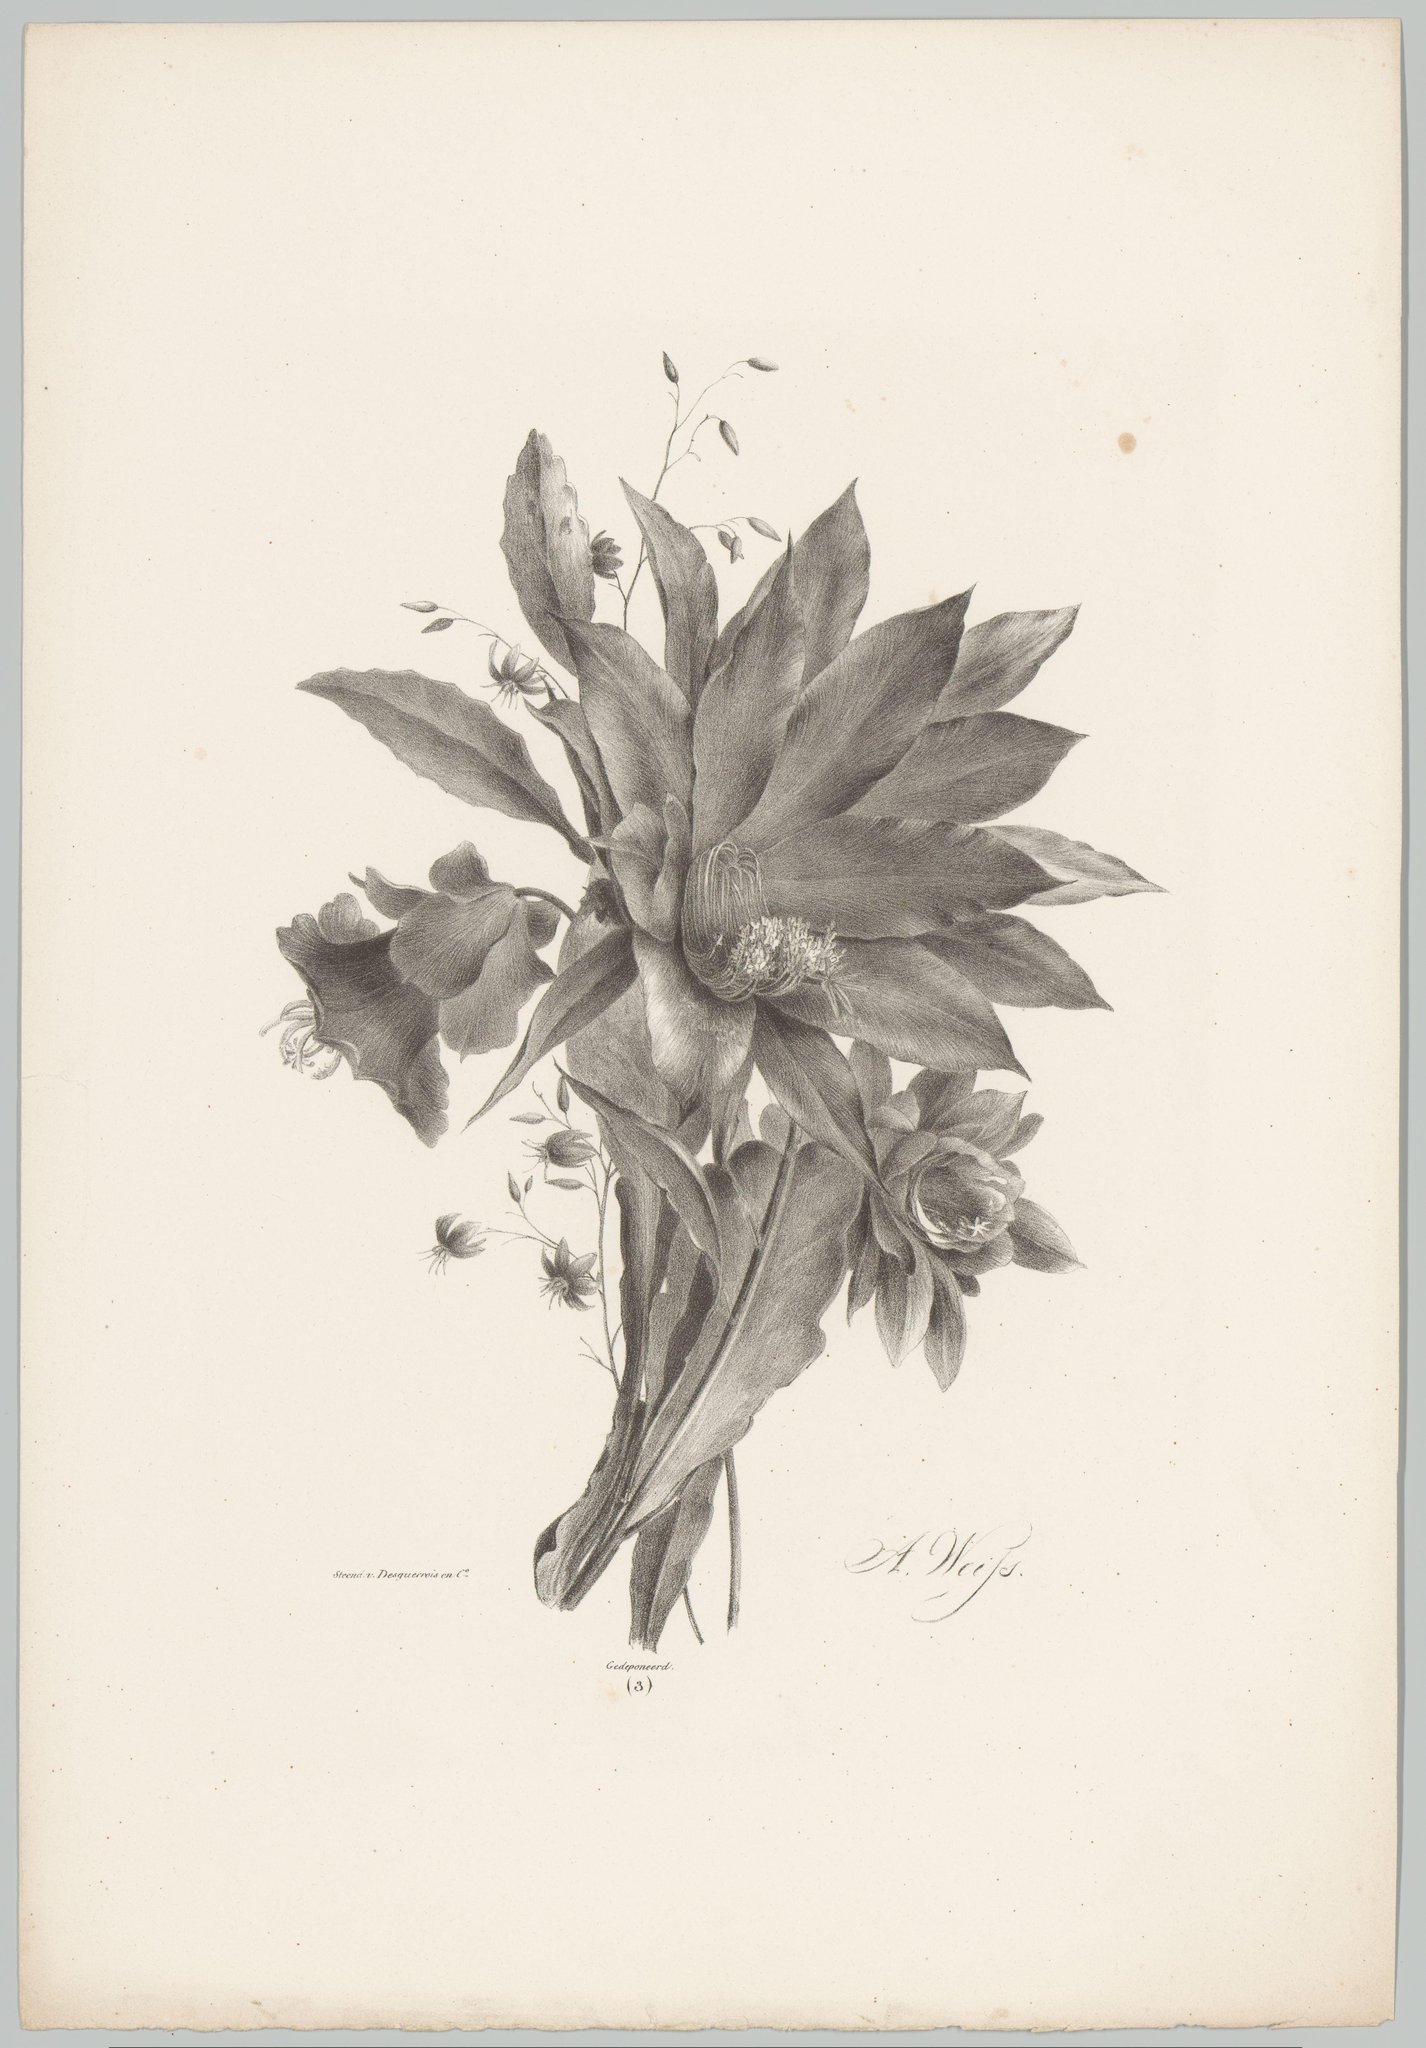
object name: print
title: Bloem en Fruit Studien (...) 10e aflevering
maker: anton weiss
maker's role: draughtsman, print maker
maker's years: 1801-1851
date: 1836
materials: paper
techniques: lithograph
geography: amsterdam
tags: flowers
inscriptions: : ‘Gedeponeerd.’, collector's mark: Lugt 2228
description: Onderdeel van een omslag met een serie van eenenveertig lithografieën van bloemen en fruit.